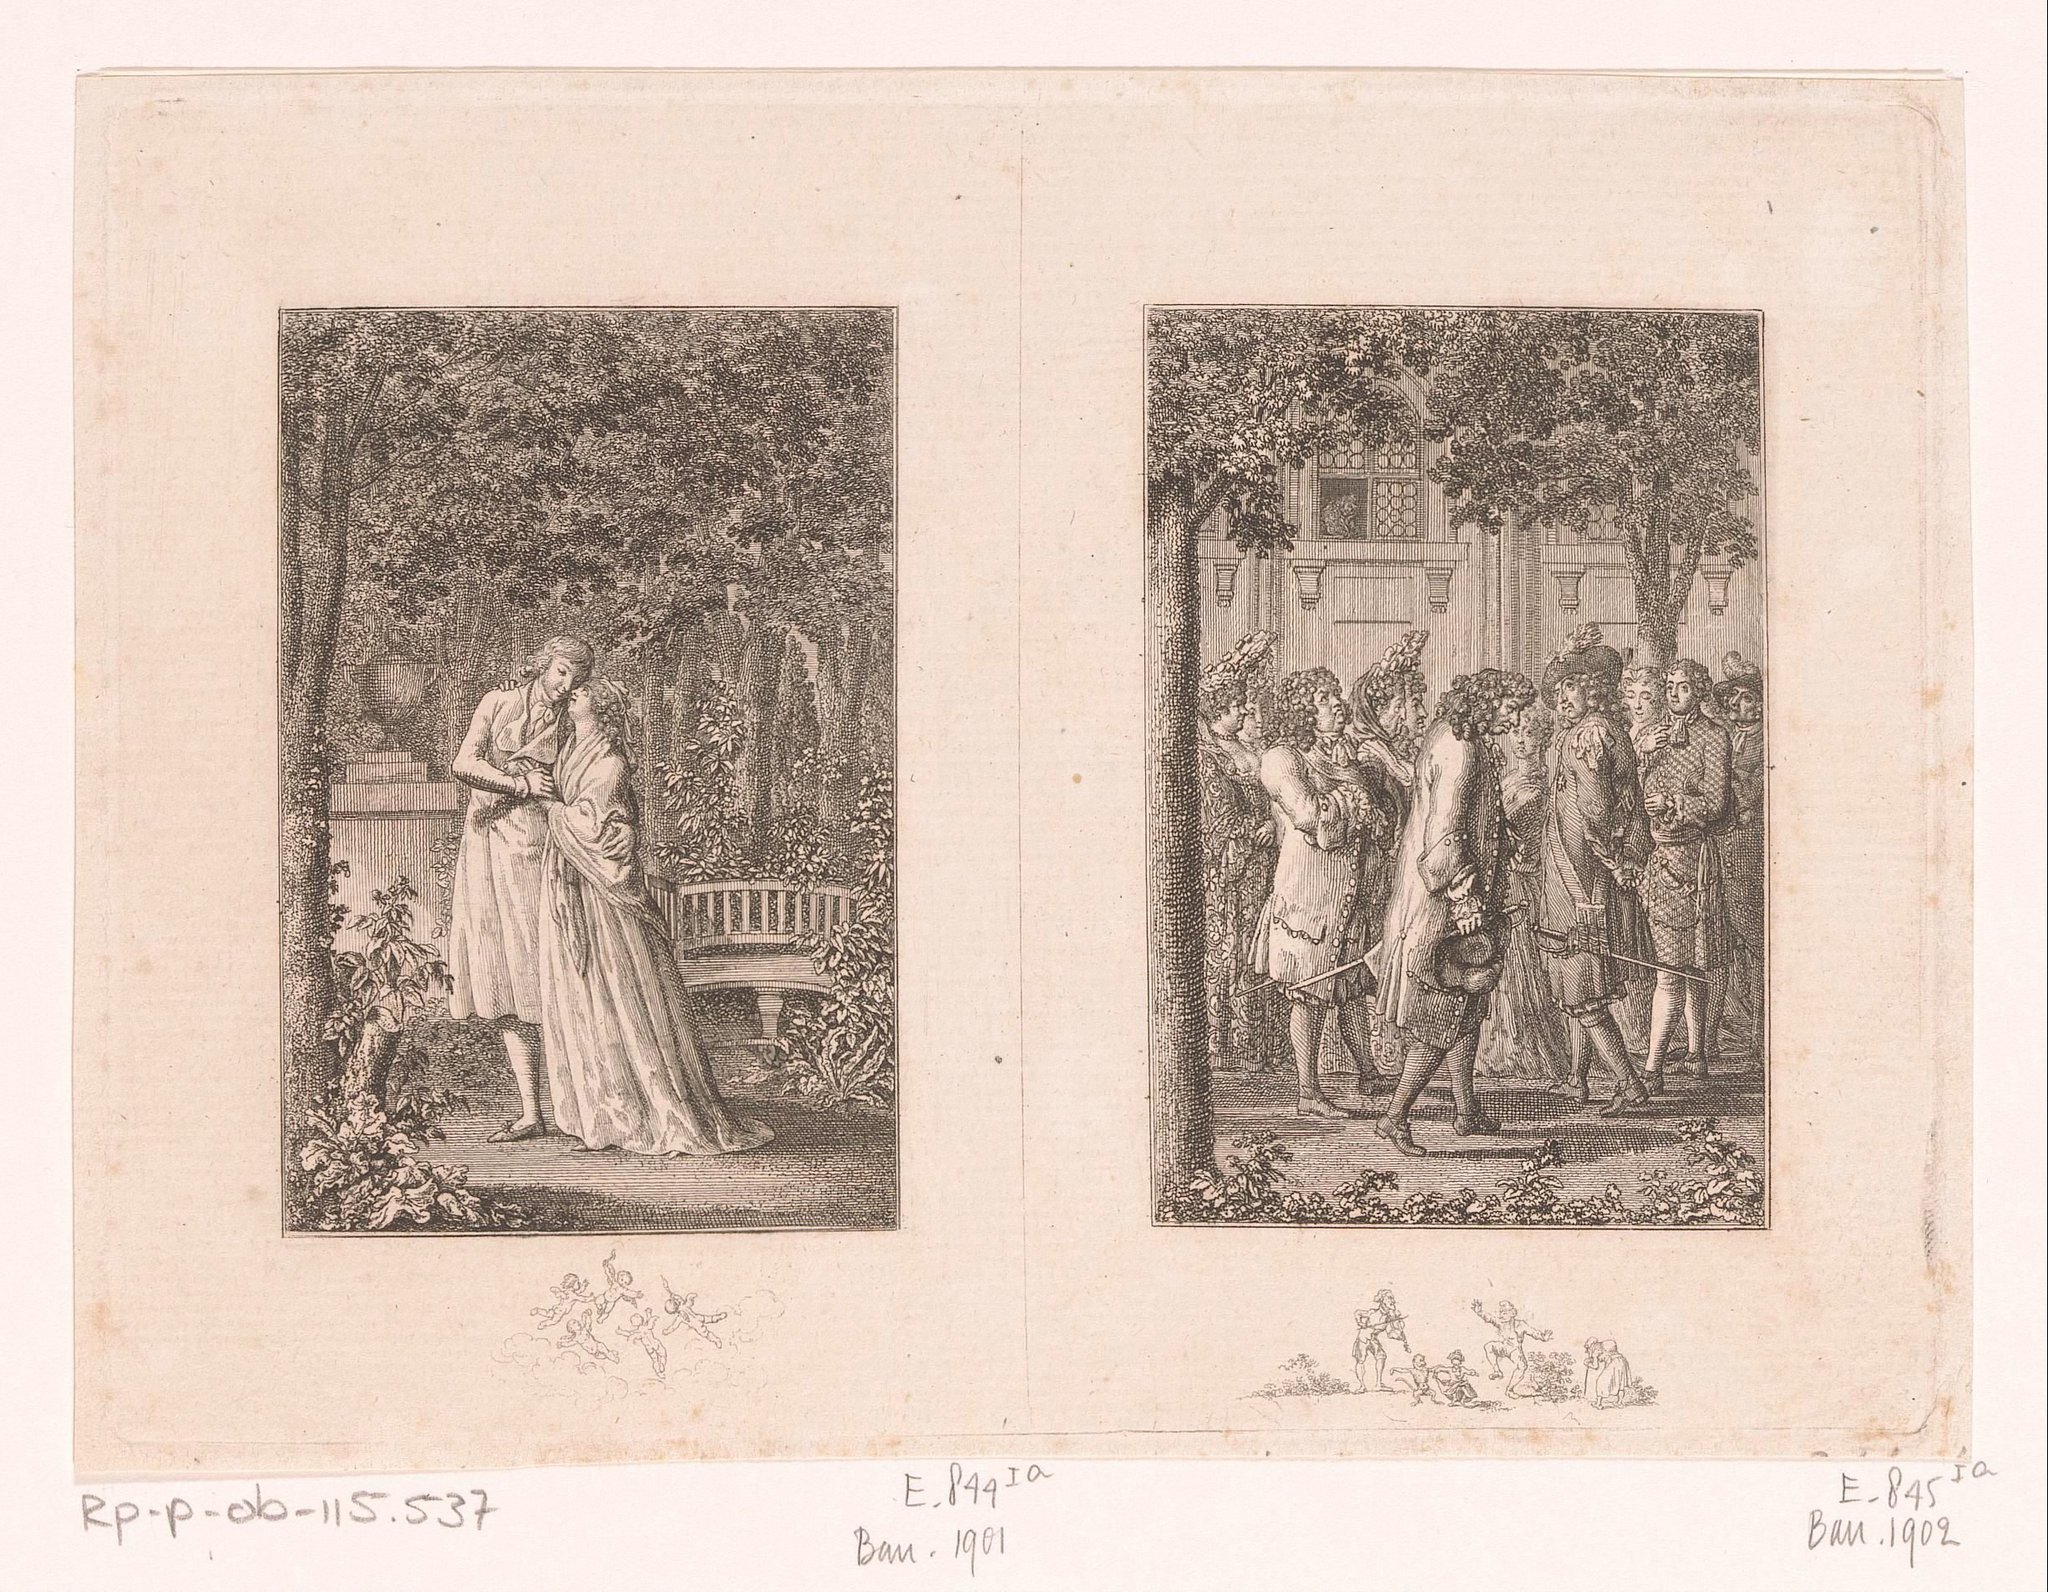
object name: print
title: Twee voorstellingen uit de verhalen van Wilhelm Gottlieb Becker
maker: daniel nikolaus chodowiecki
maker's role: draughtsman, print maker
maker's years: 1726-1801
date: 1797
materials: paper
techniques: etching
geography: berlin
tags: crowd, mob, literature, (lovers) embracing each other, 'symplegma', garden, open window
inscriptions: collector's mark: Lugt 2228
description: Latere staat gebruikt voor: Becker, Wilhelm Gottlieb. Almanach und Taschenbuch zum geselligen Vergnügen von W. G. Becker für 1798. Leipzig: Voss und Comp., [1797].